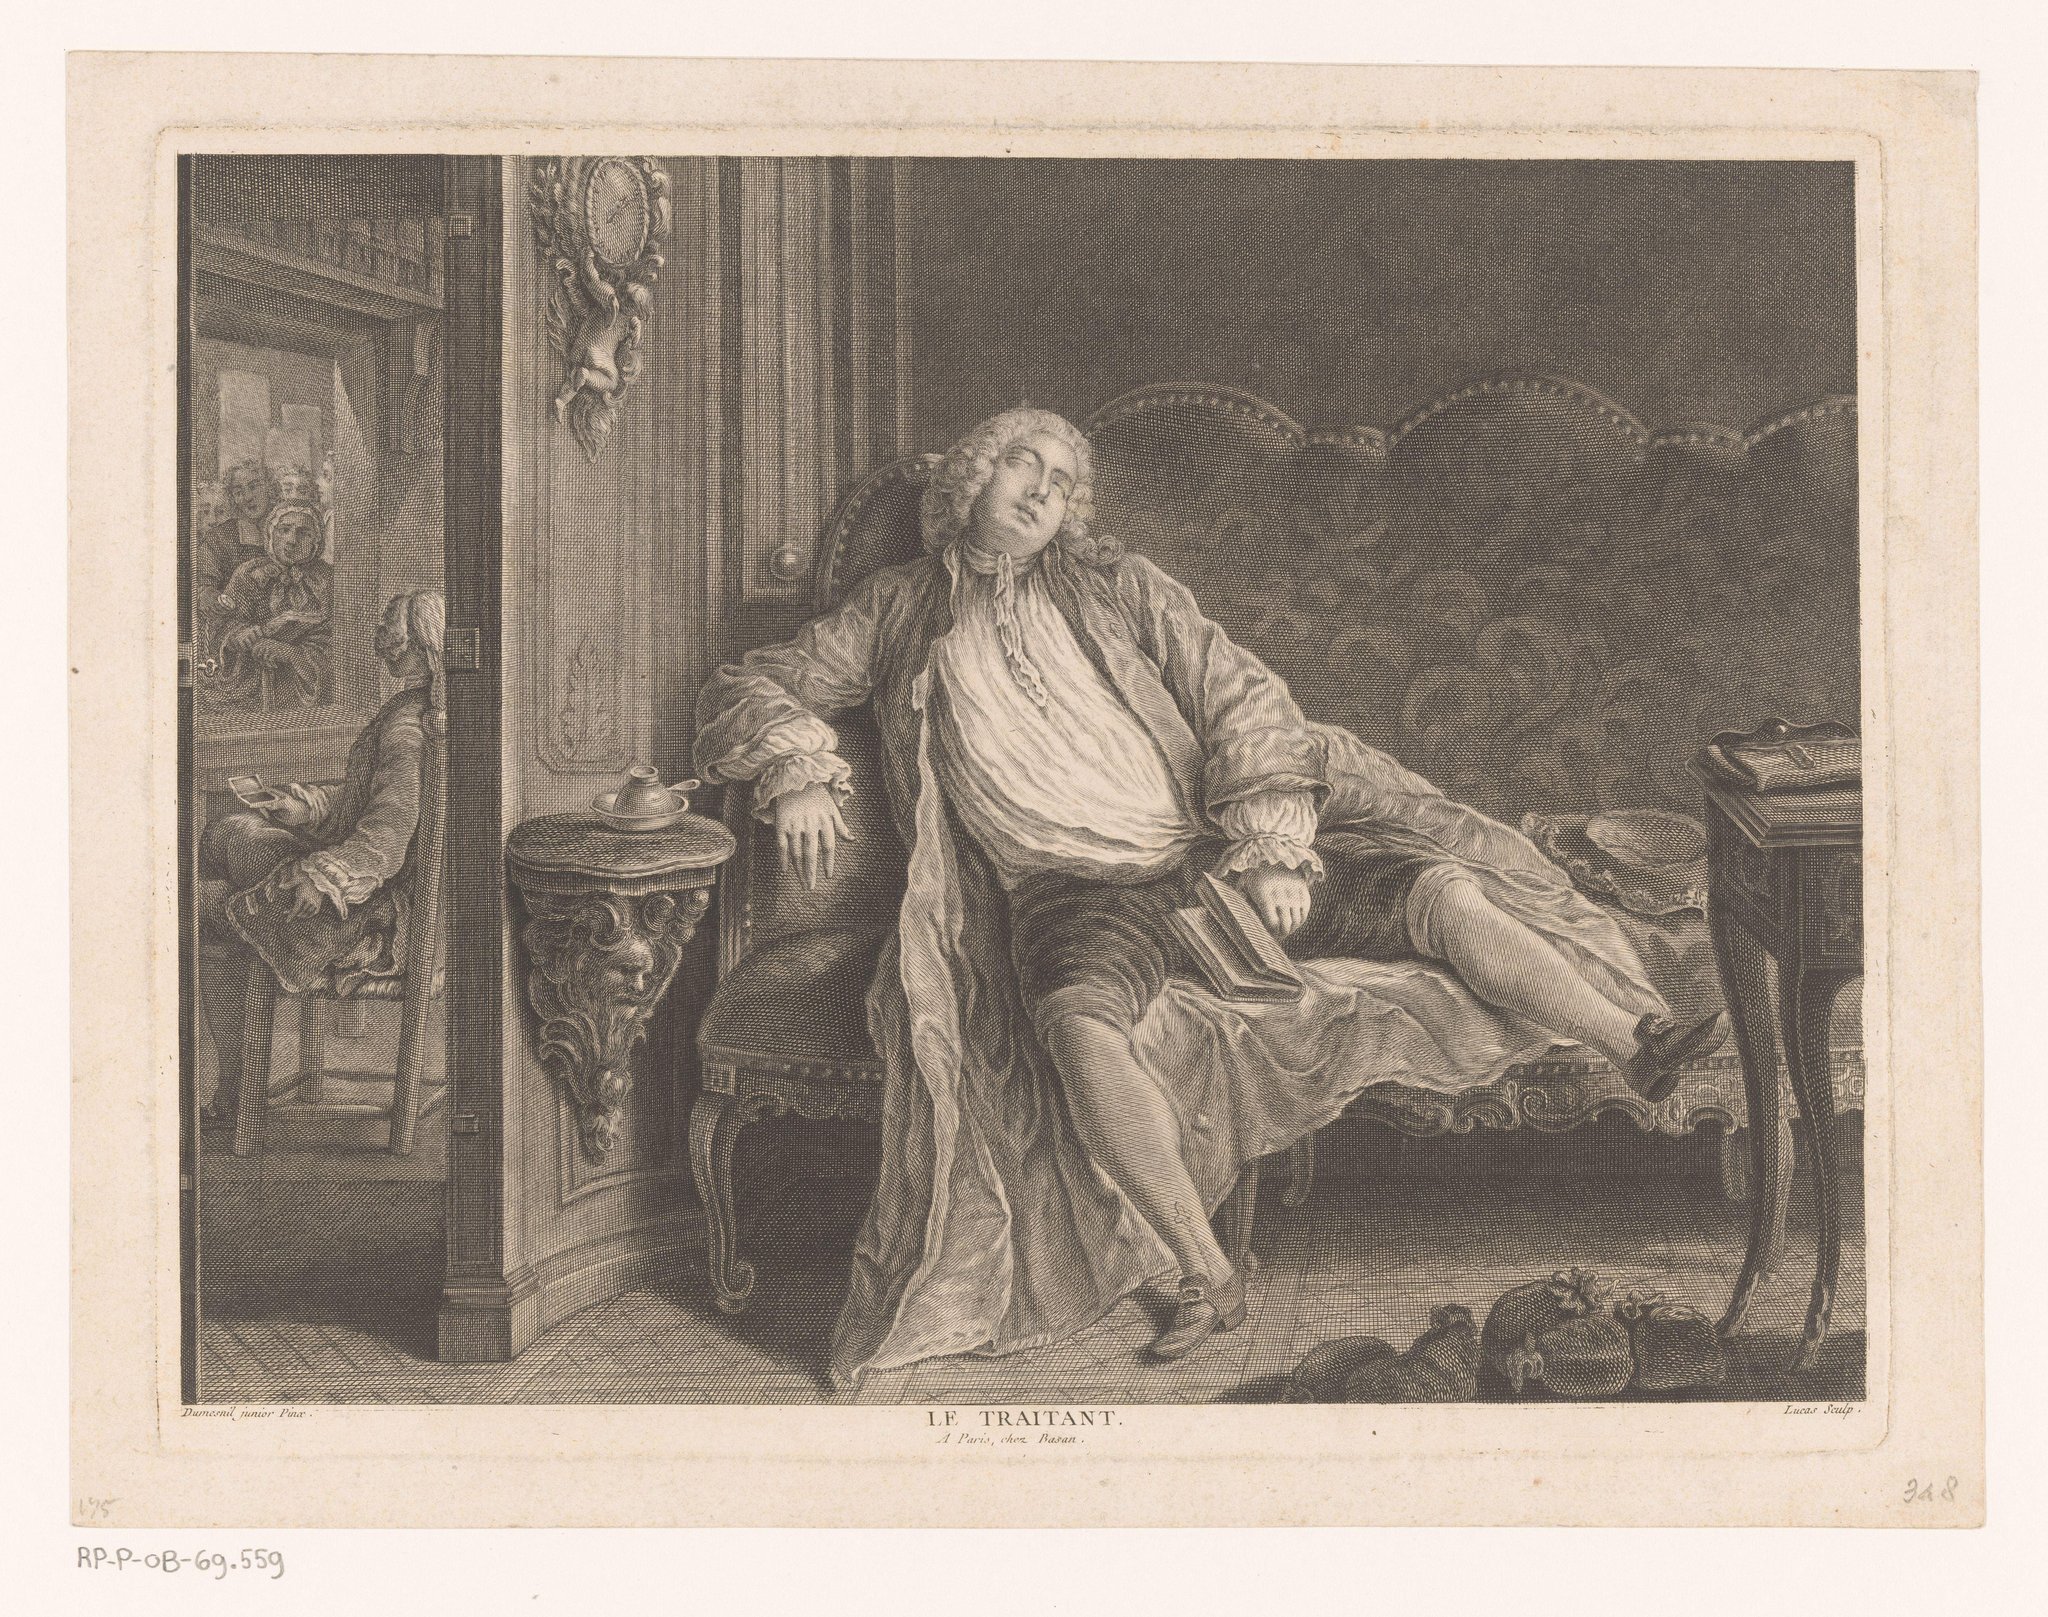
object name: print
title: Slapende man op bank met boek in zijn hand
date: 1733-1797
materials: paper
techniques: engraving, etching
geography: paris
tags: physician, doctor, sleeping; unconsciousness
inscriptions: collector's mark: Lugt 2228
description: Links biedt een deuropening zicht op een rij wachtende mensen. Een man toont zijn horloge.